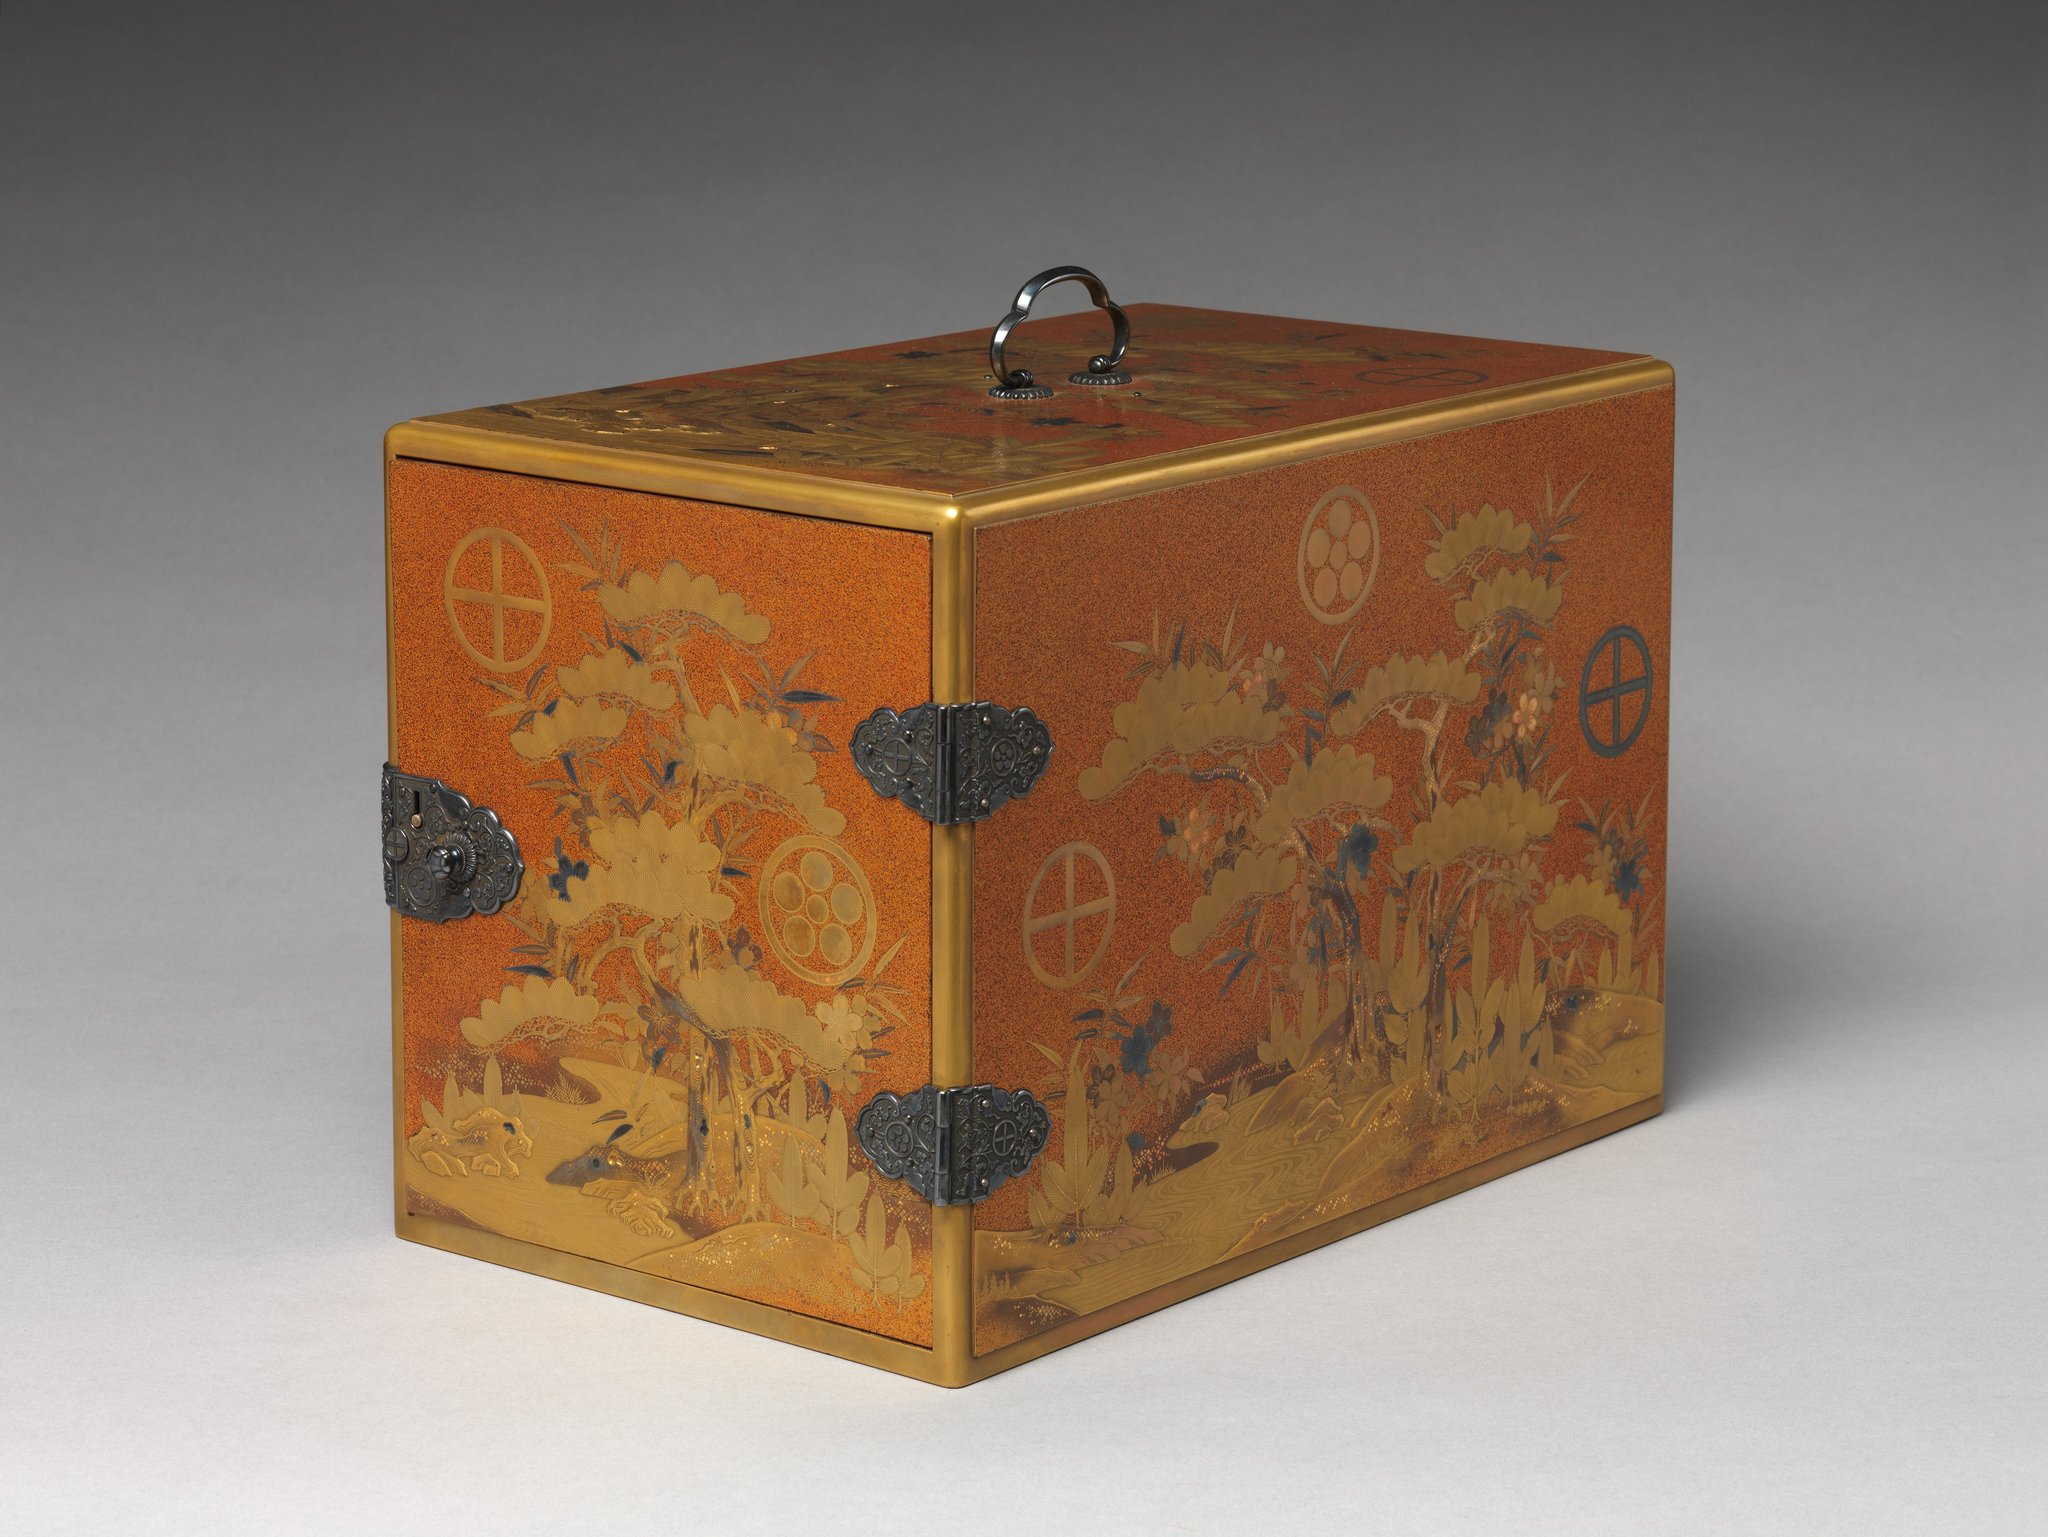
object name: cabinet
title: Cabinet with Design of Pine, Bamboo, and Cherry Blossom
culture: japanese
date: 1801-1900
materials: gold, lacquer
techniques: maki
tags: bamboo